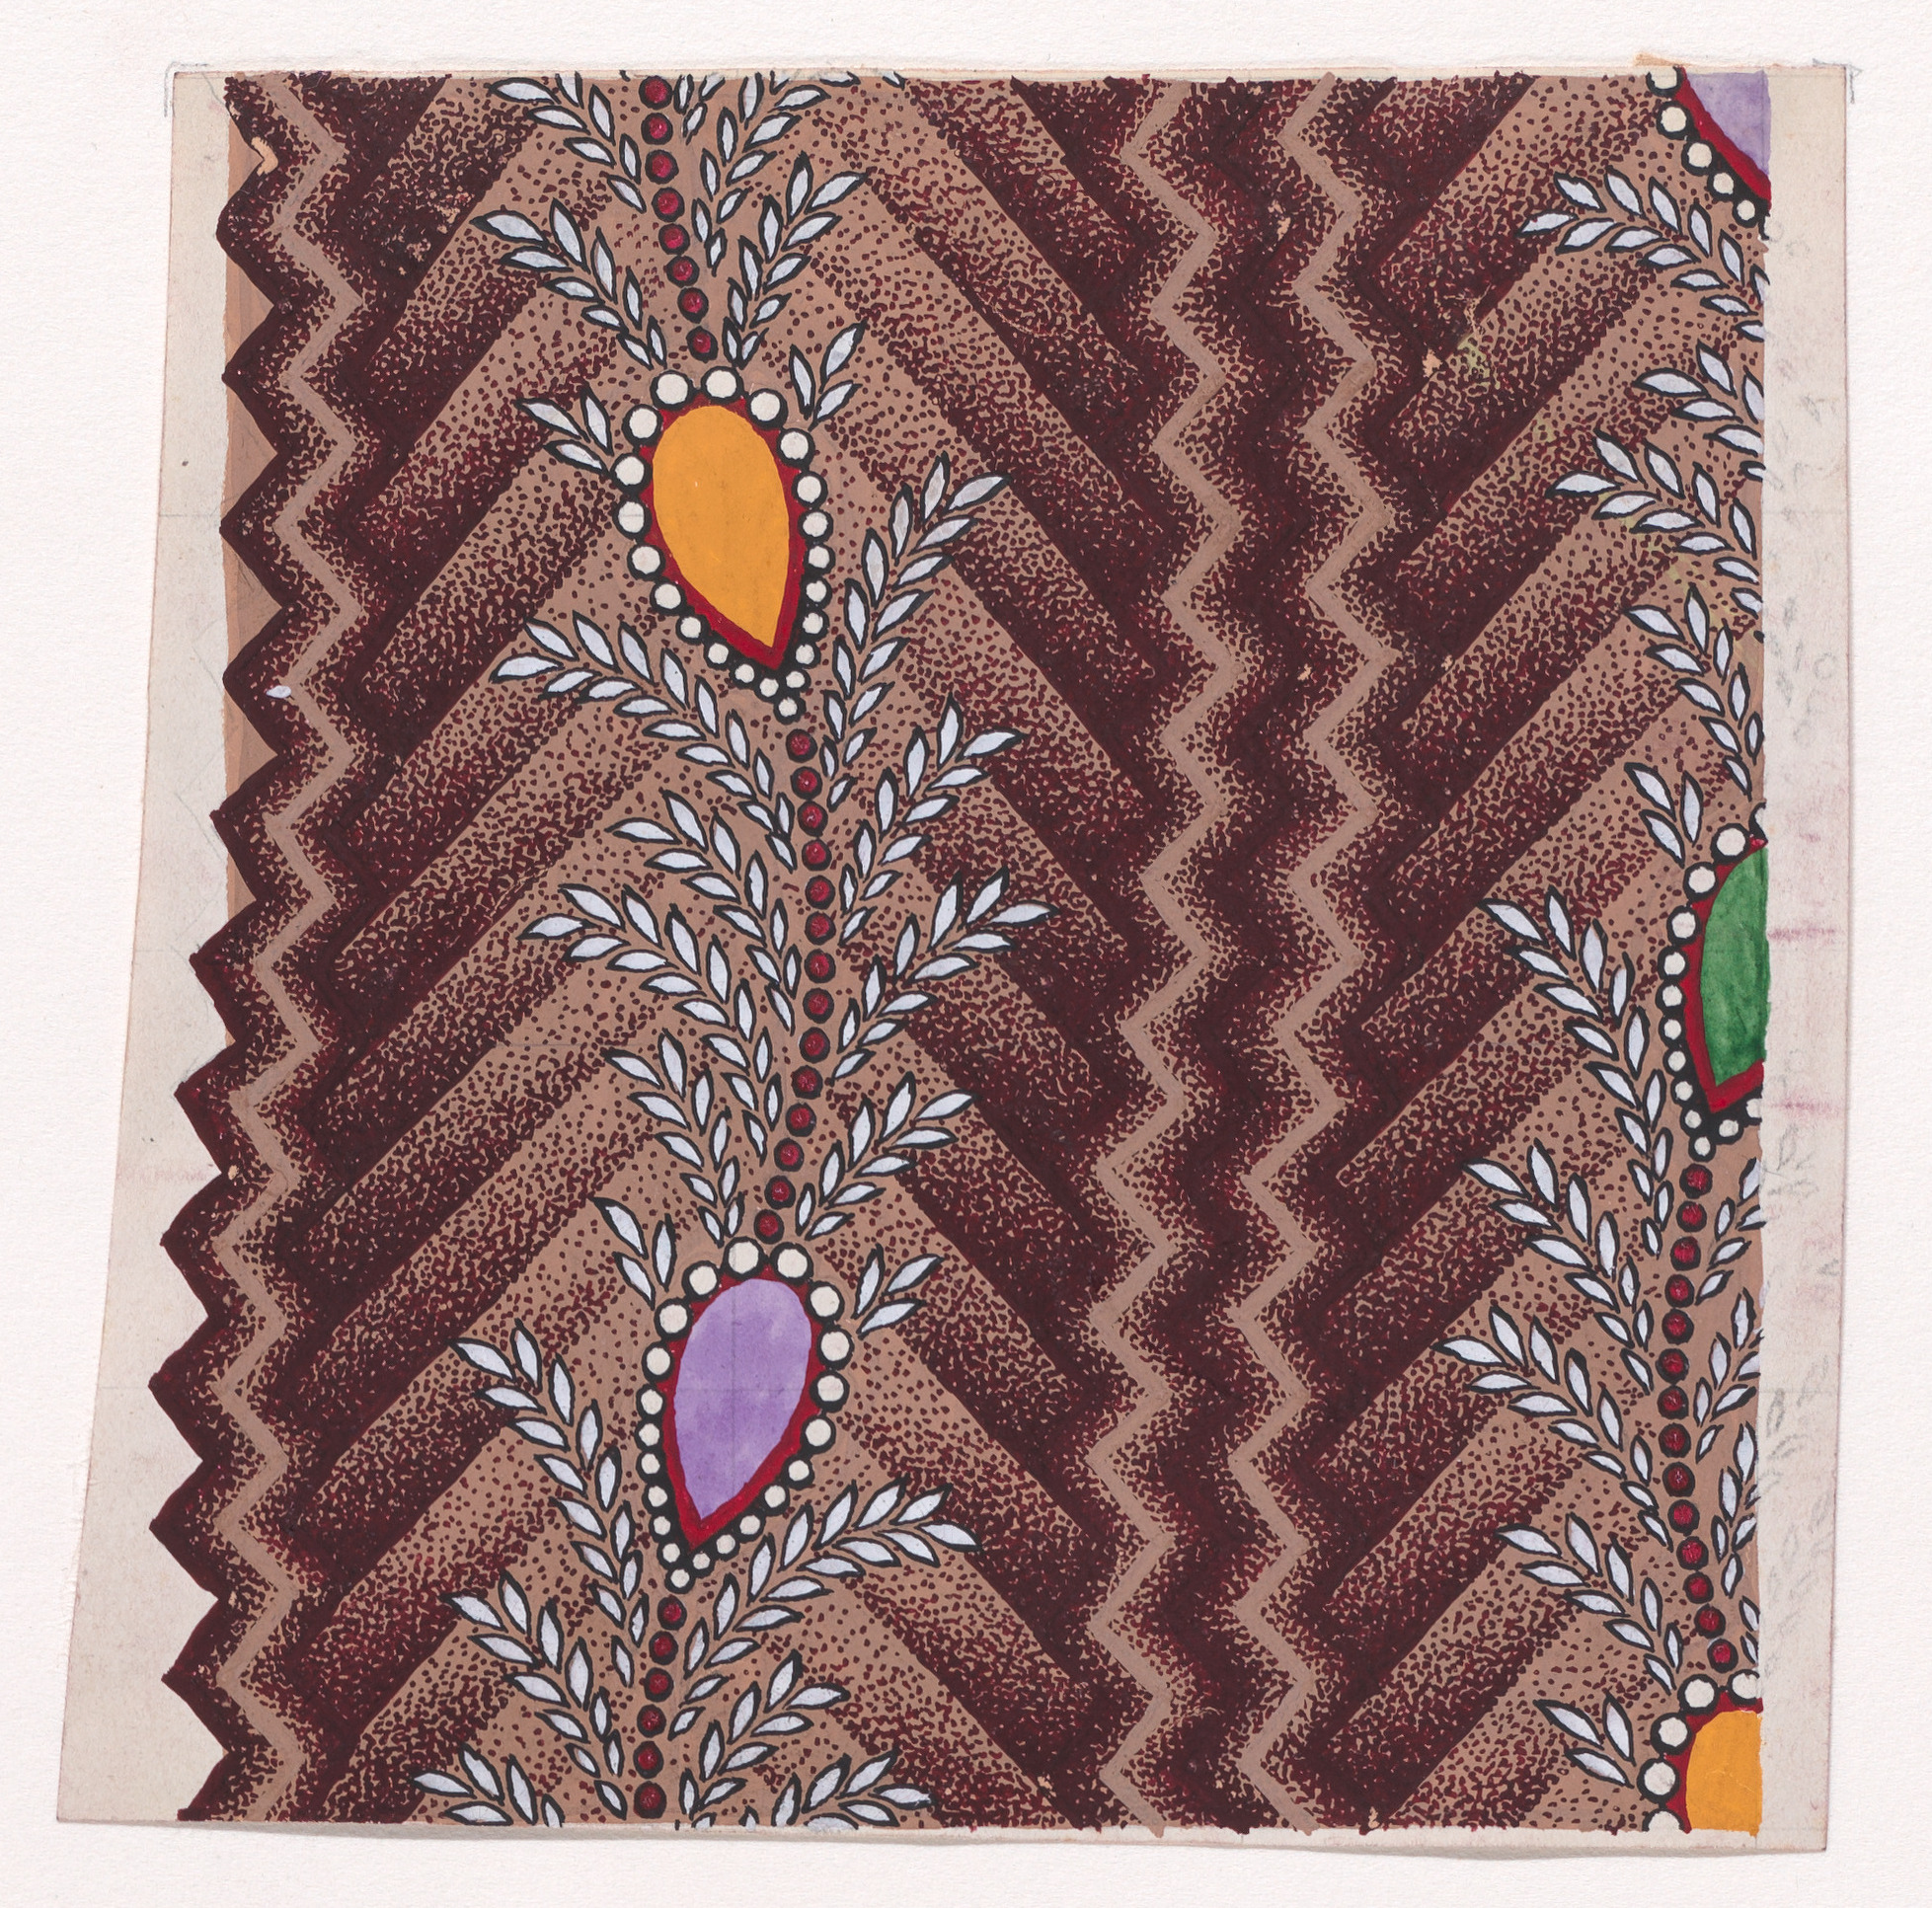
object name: drawing ornament architecture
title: Textile Design with Vertical Undulating Garlands of Pearls and Inverted Teardrops Framed with Pearls with Offsetting Wheat Ears Separated by a Vertical Zig-Zagging Ribbon over a Chevron Background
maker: anonymous, alsatian, 19th century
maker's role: artist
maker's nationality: alsatian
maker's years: 1800-1900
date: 1840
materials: gouache